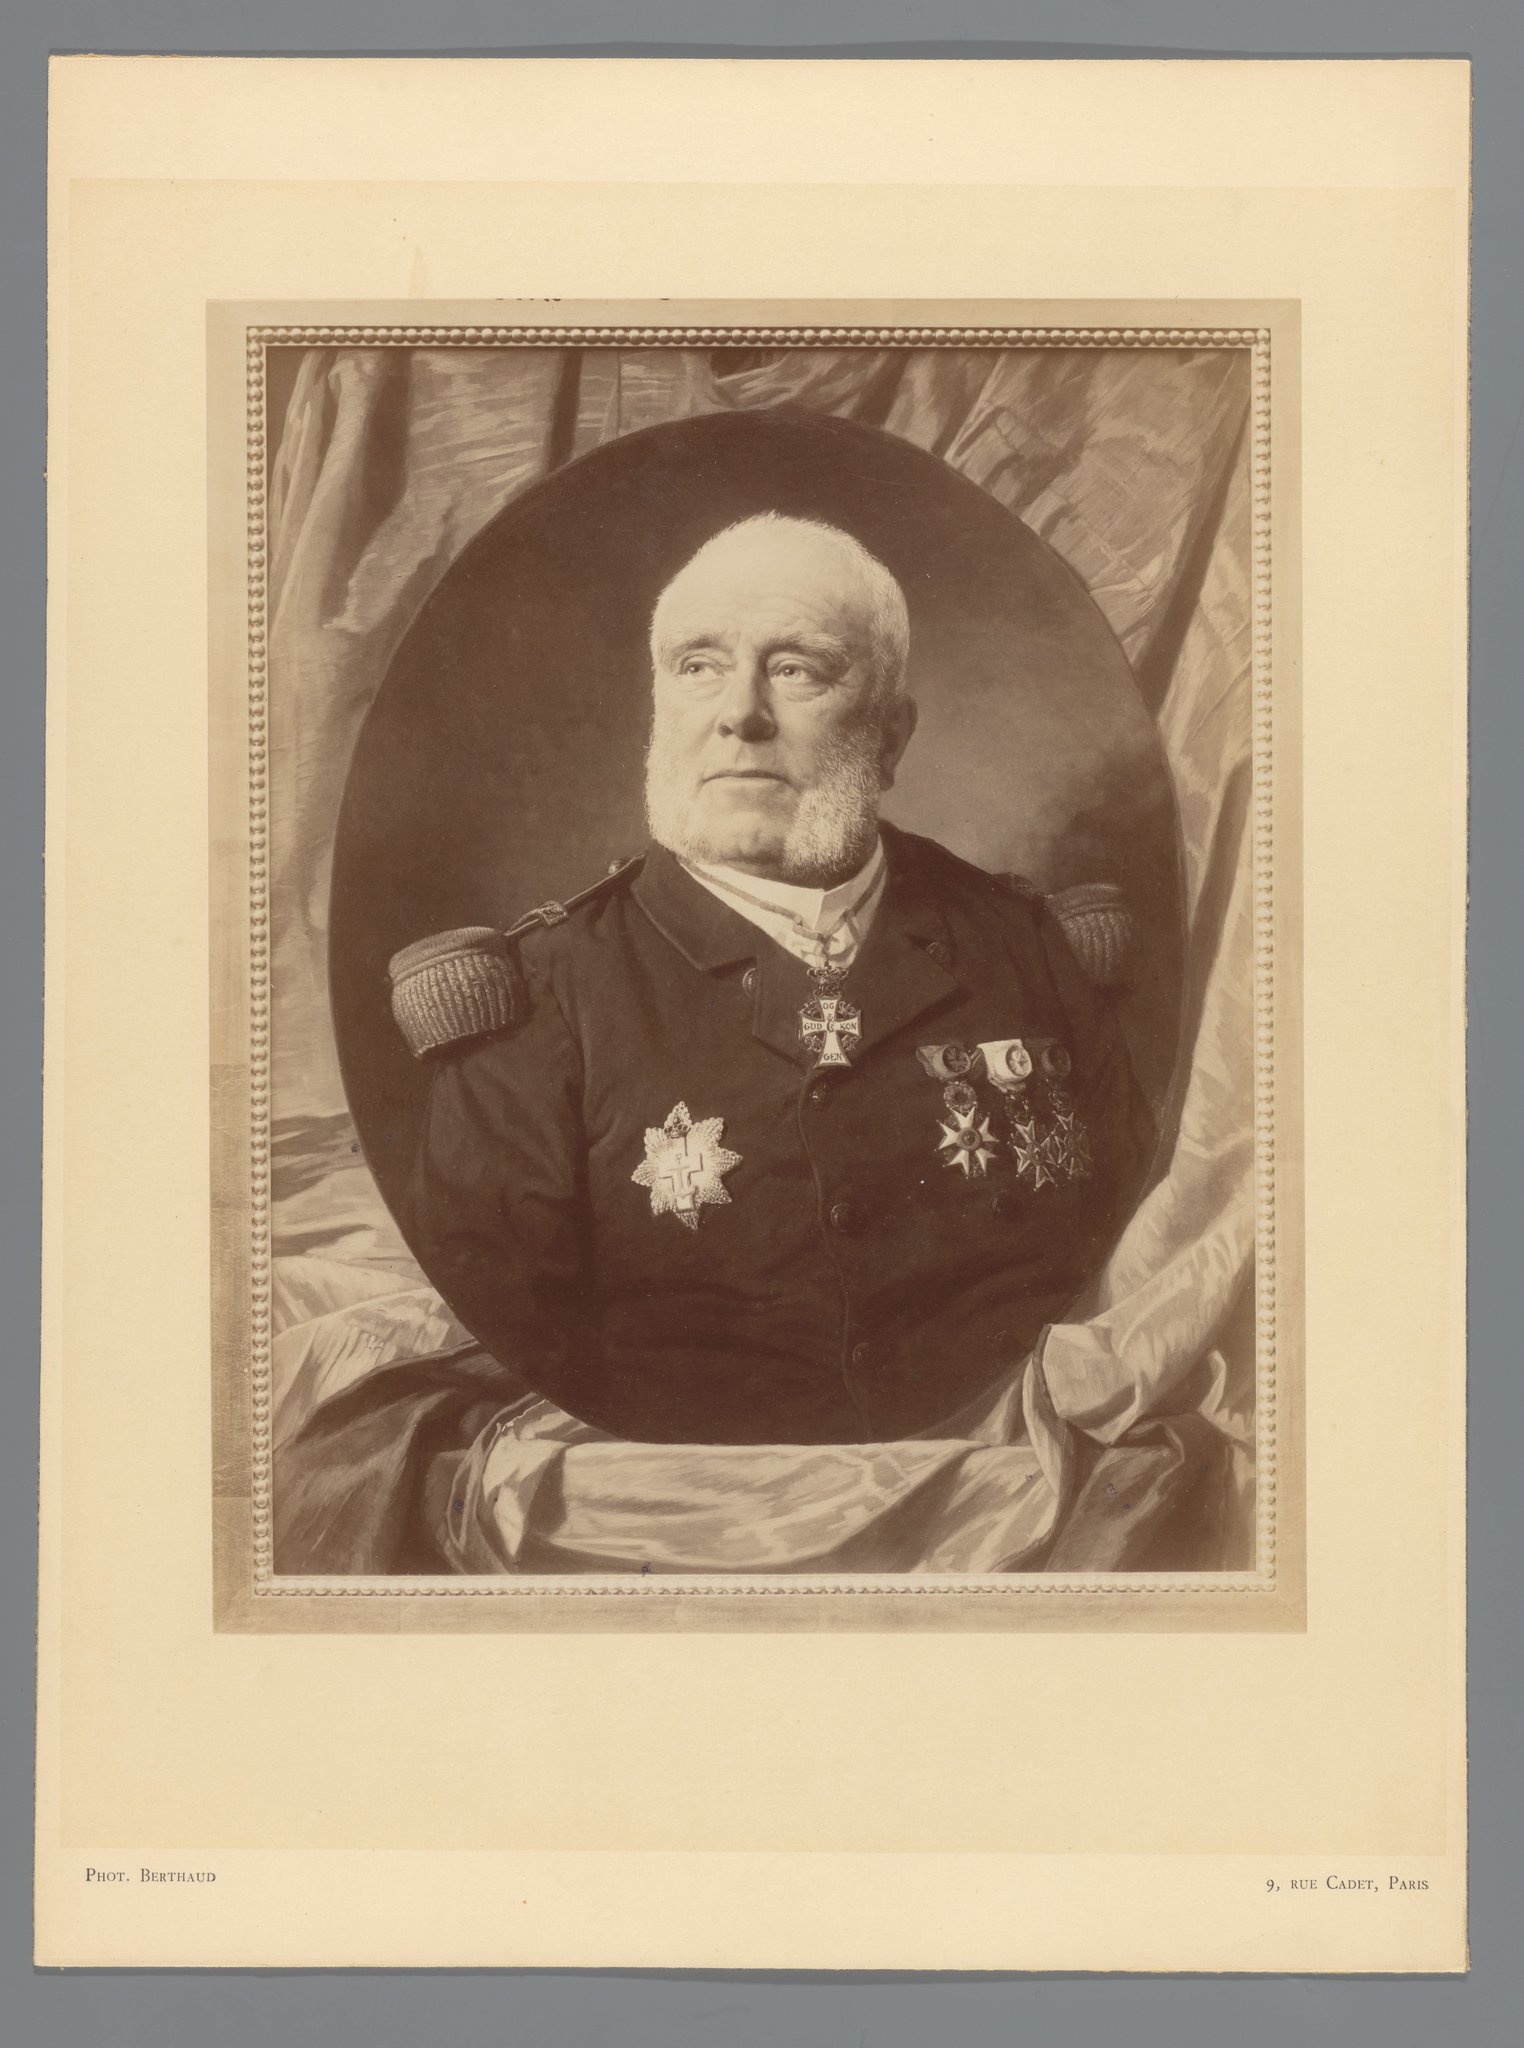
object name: photograph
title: Fotoreproductie van een geschilderd portret van een militair in uniform, aangeduid als commandant Littré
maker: michel berthaud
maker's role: publisher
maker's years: 1845-1912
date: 1860-1890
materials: cardboard, paper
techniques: albumen print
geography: paris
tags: commander-in-chief, general, marshal, paris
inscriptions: address: ‘9, rue Cadet, Paris’